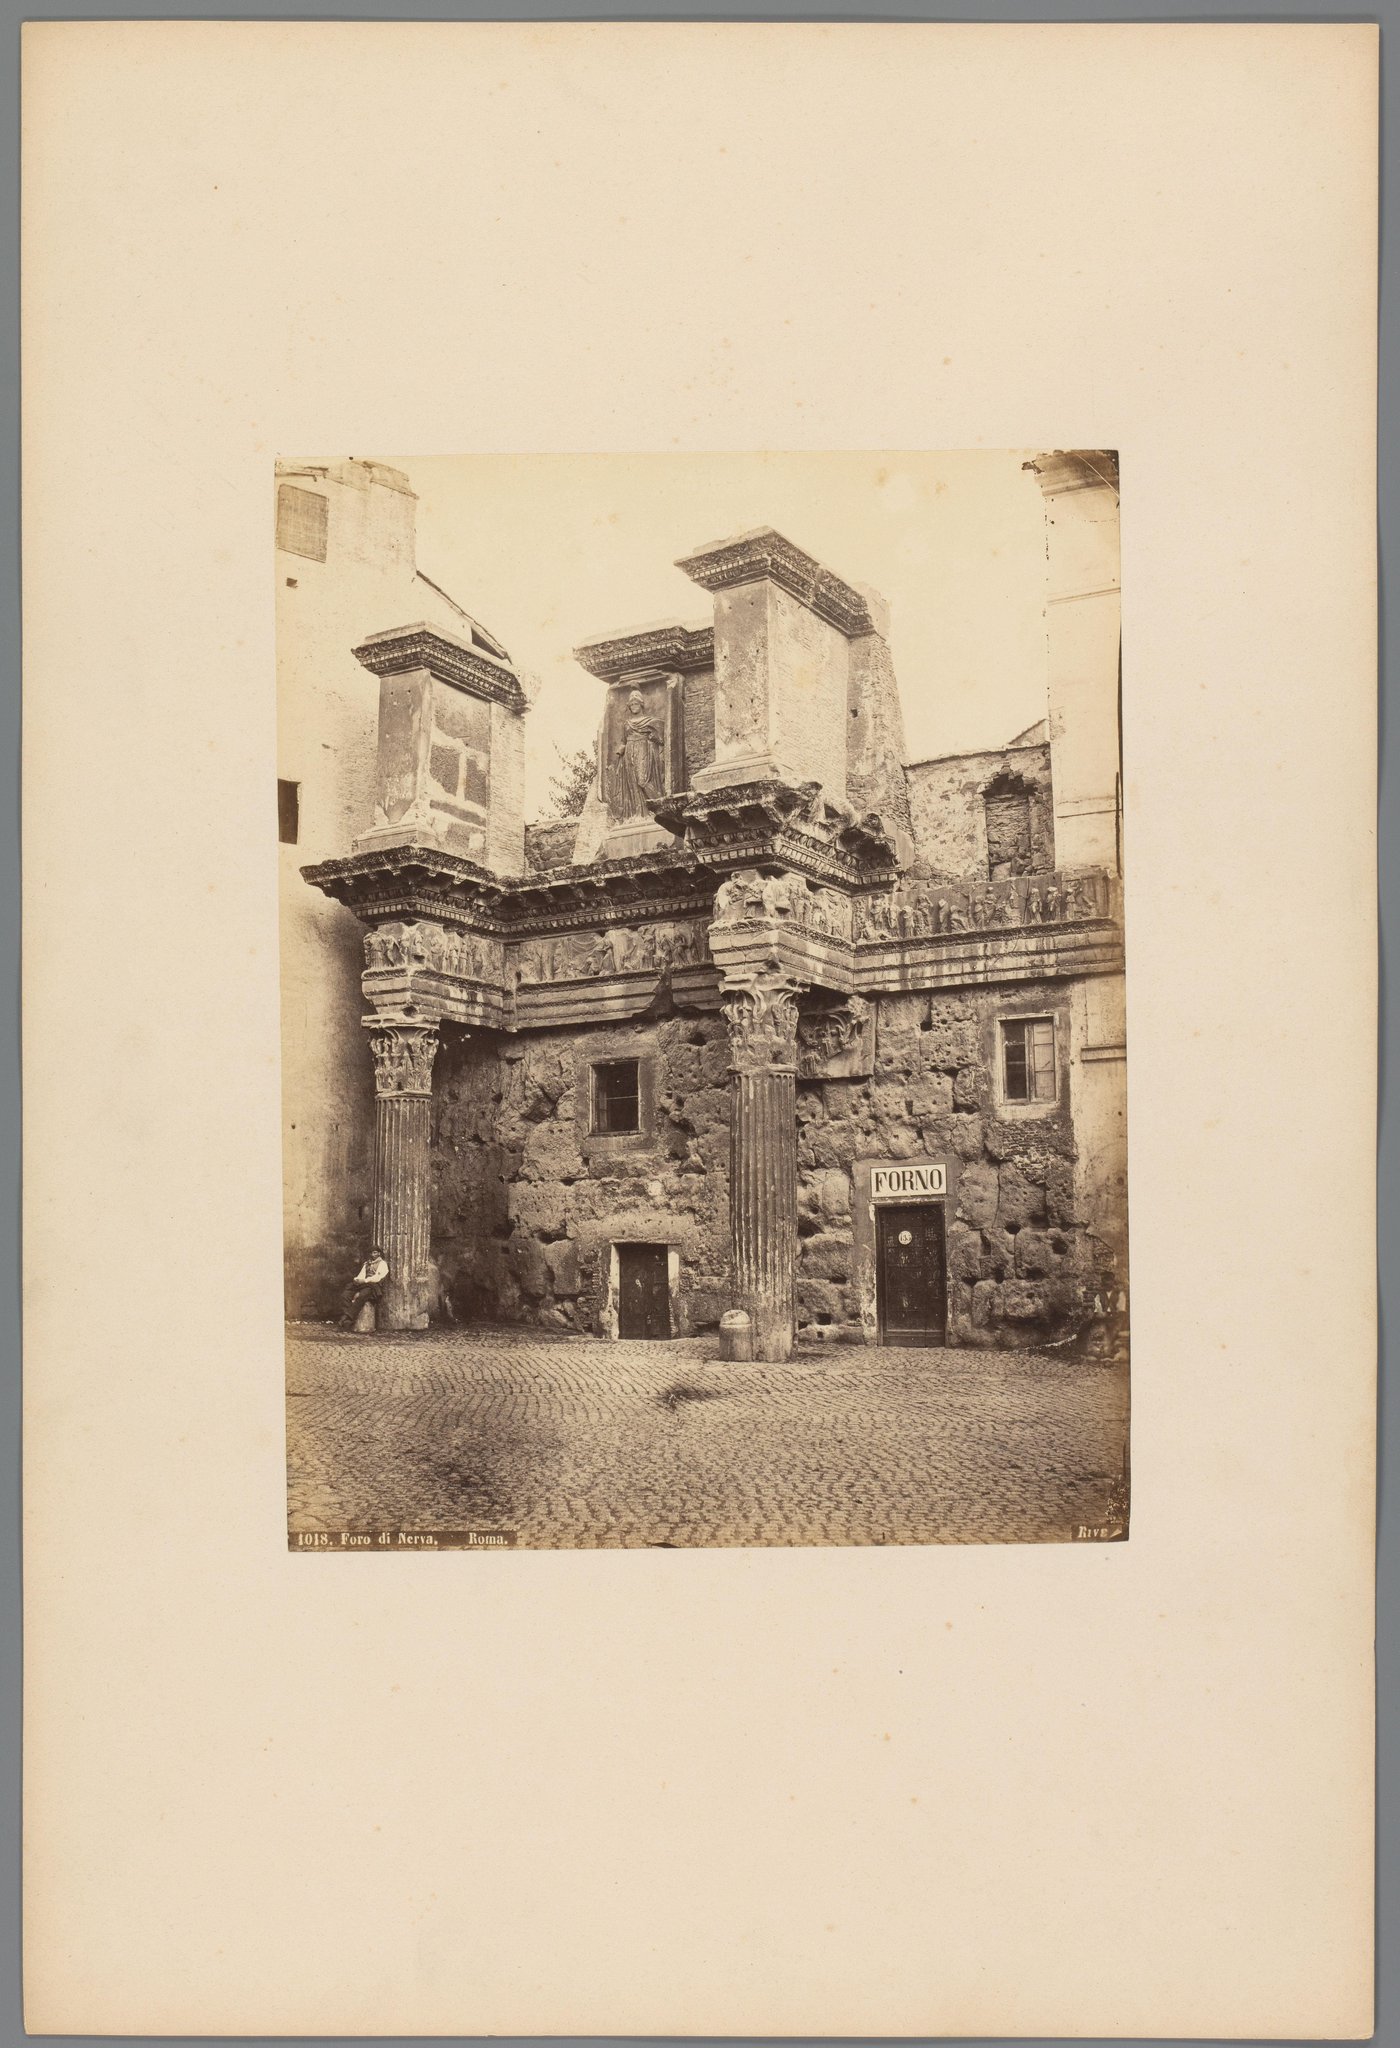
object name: photograph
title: Foro di Nerva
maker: roberto rive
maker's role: fotograaf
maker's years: 1825-1868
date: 1860-1889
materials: cardboard, paper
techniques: albumen print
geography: rome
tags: ruin of a building ~ architecture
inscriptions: number: ‘1018.’